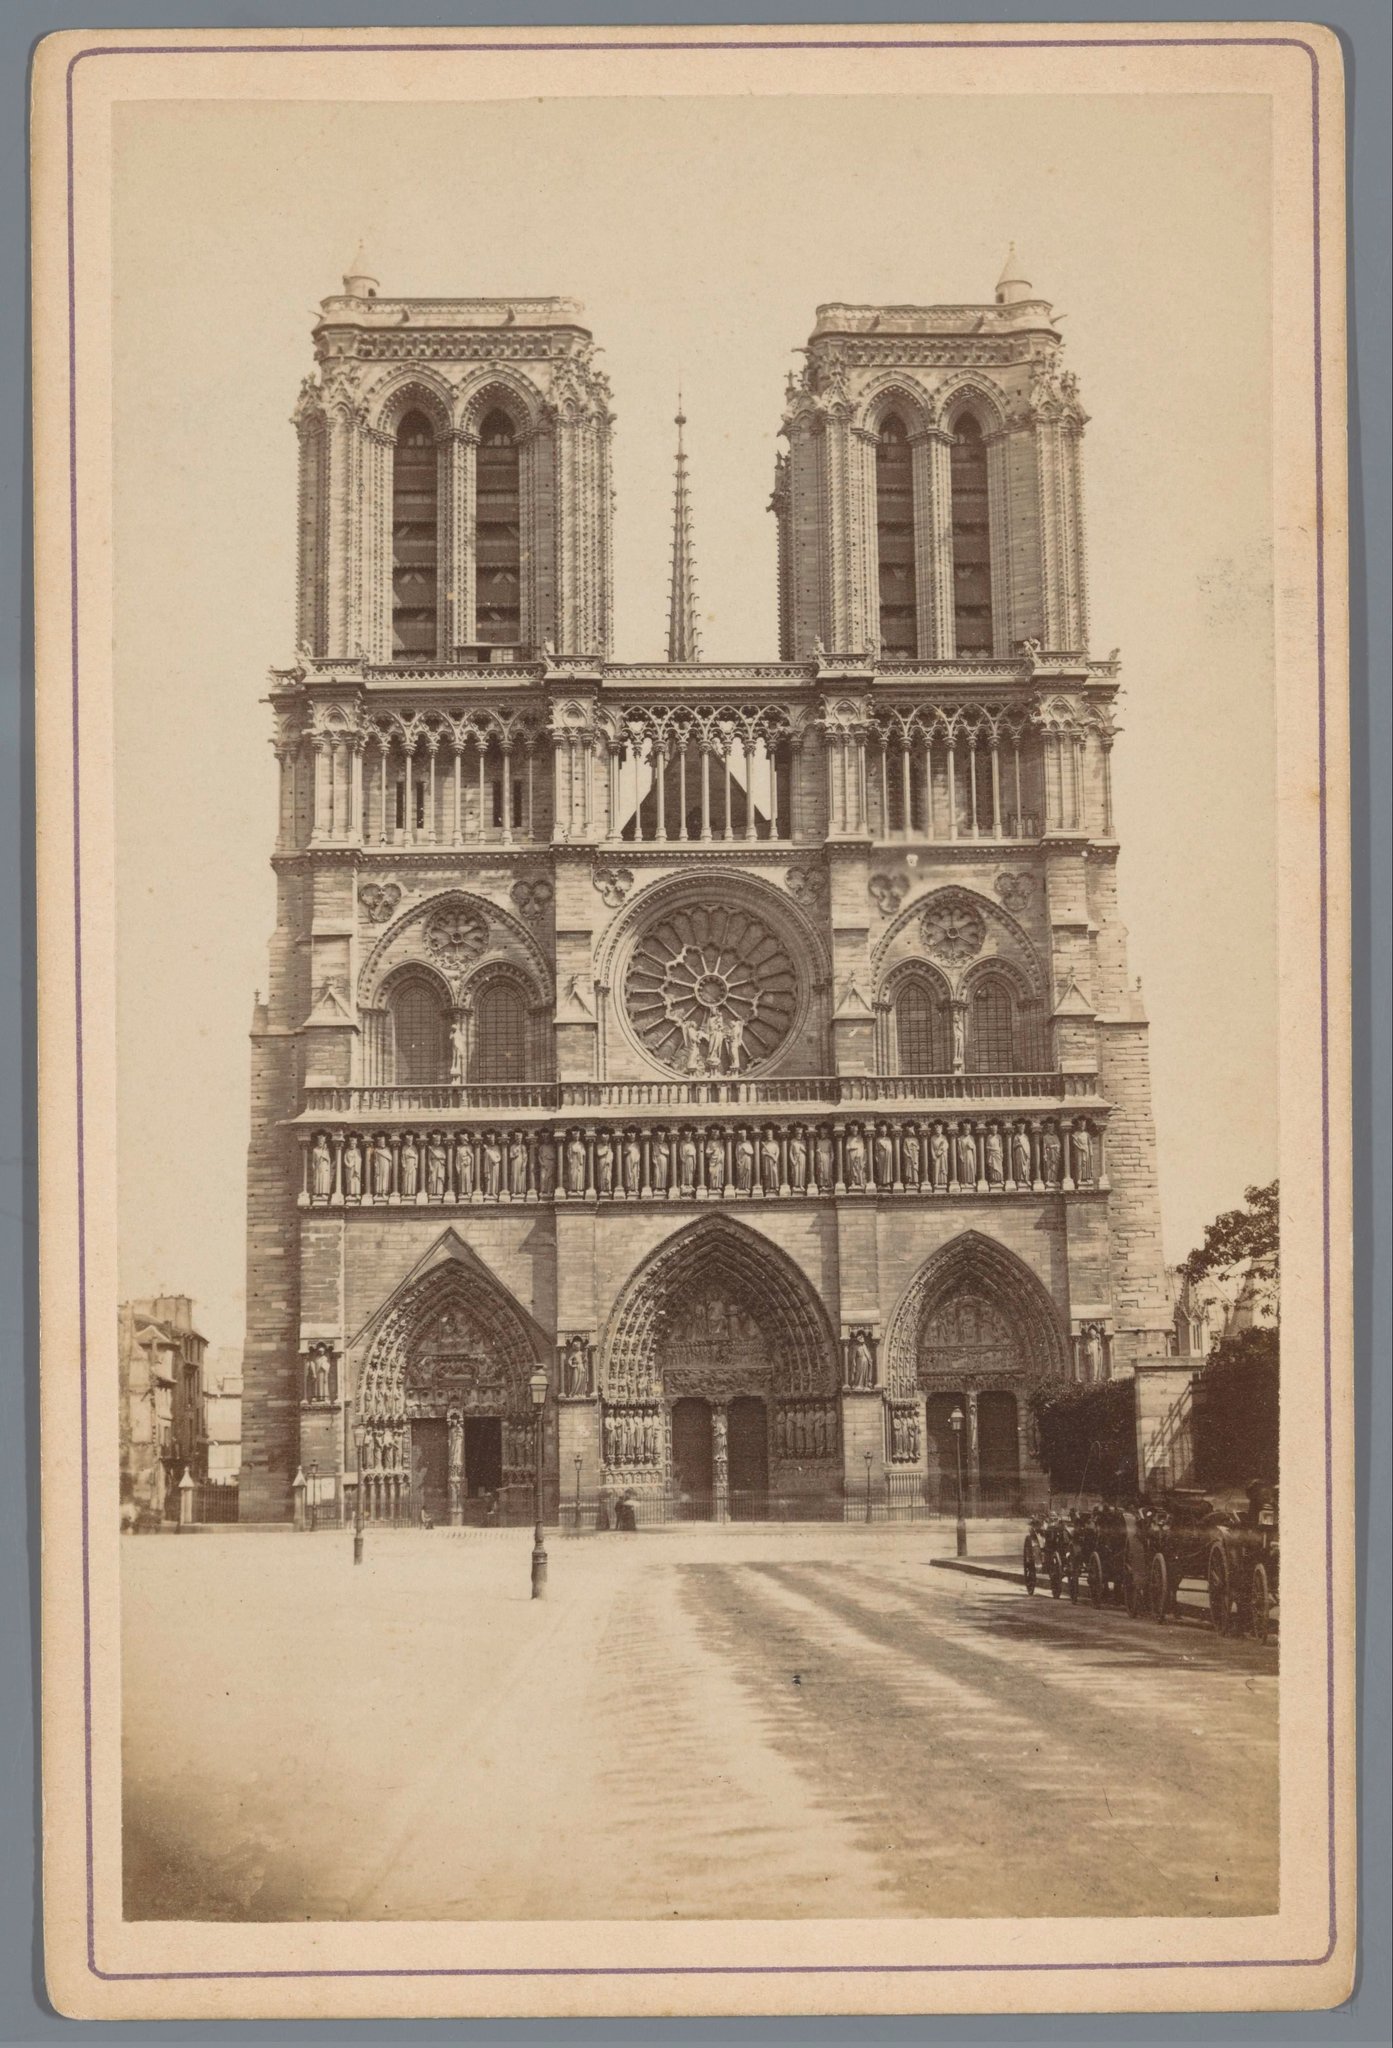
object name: cabinet photograph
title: Voorgevel van de Notre-Dame te Parijs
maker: Anonymous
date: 1865-1875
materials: cardboard, photographic support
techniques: albumen print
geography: france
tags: church (exterior), façade (of house or building)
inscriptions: inscription: ‘Notre-Dame’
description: Zie ook RP-F-00-1034 voor een ander exemplaar.